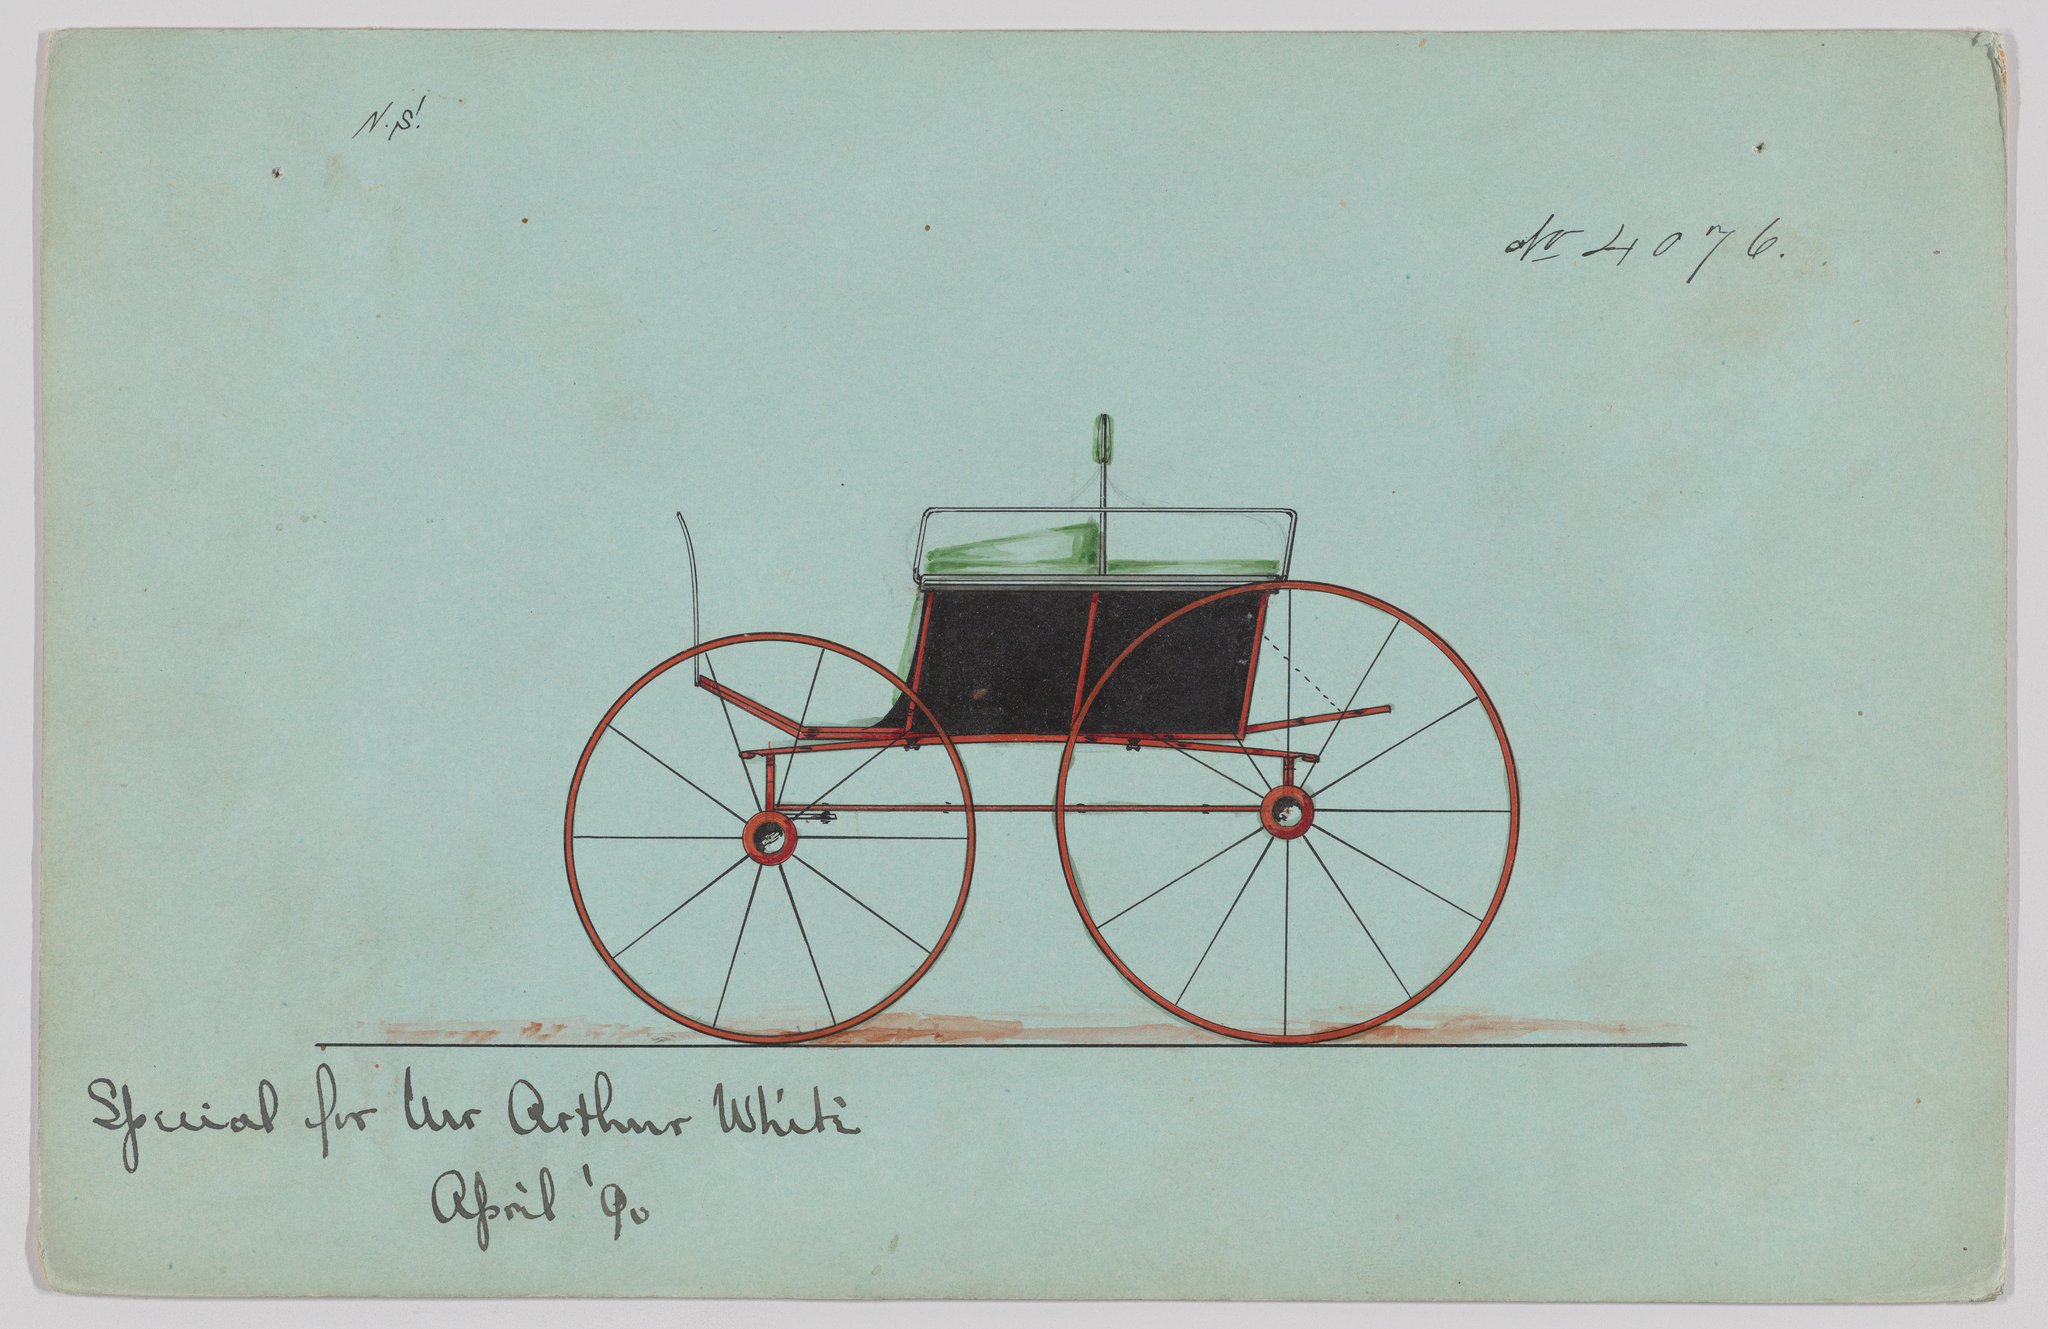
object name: drawing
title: Design for Dog Cart or 2 Wheeler, no. 4076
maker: brewster & co.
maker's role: manufacturer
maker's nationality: american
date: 1890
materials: gouache, gum arabic, ink, watercolor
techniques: pen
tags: carriages